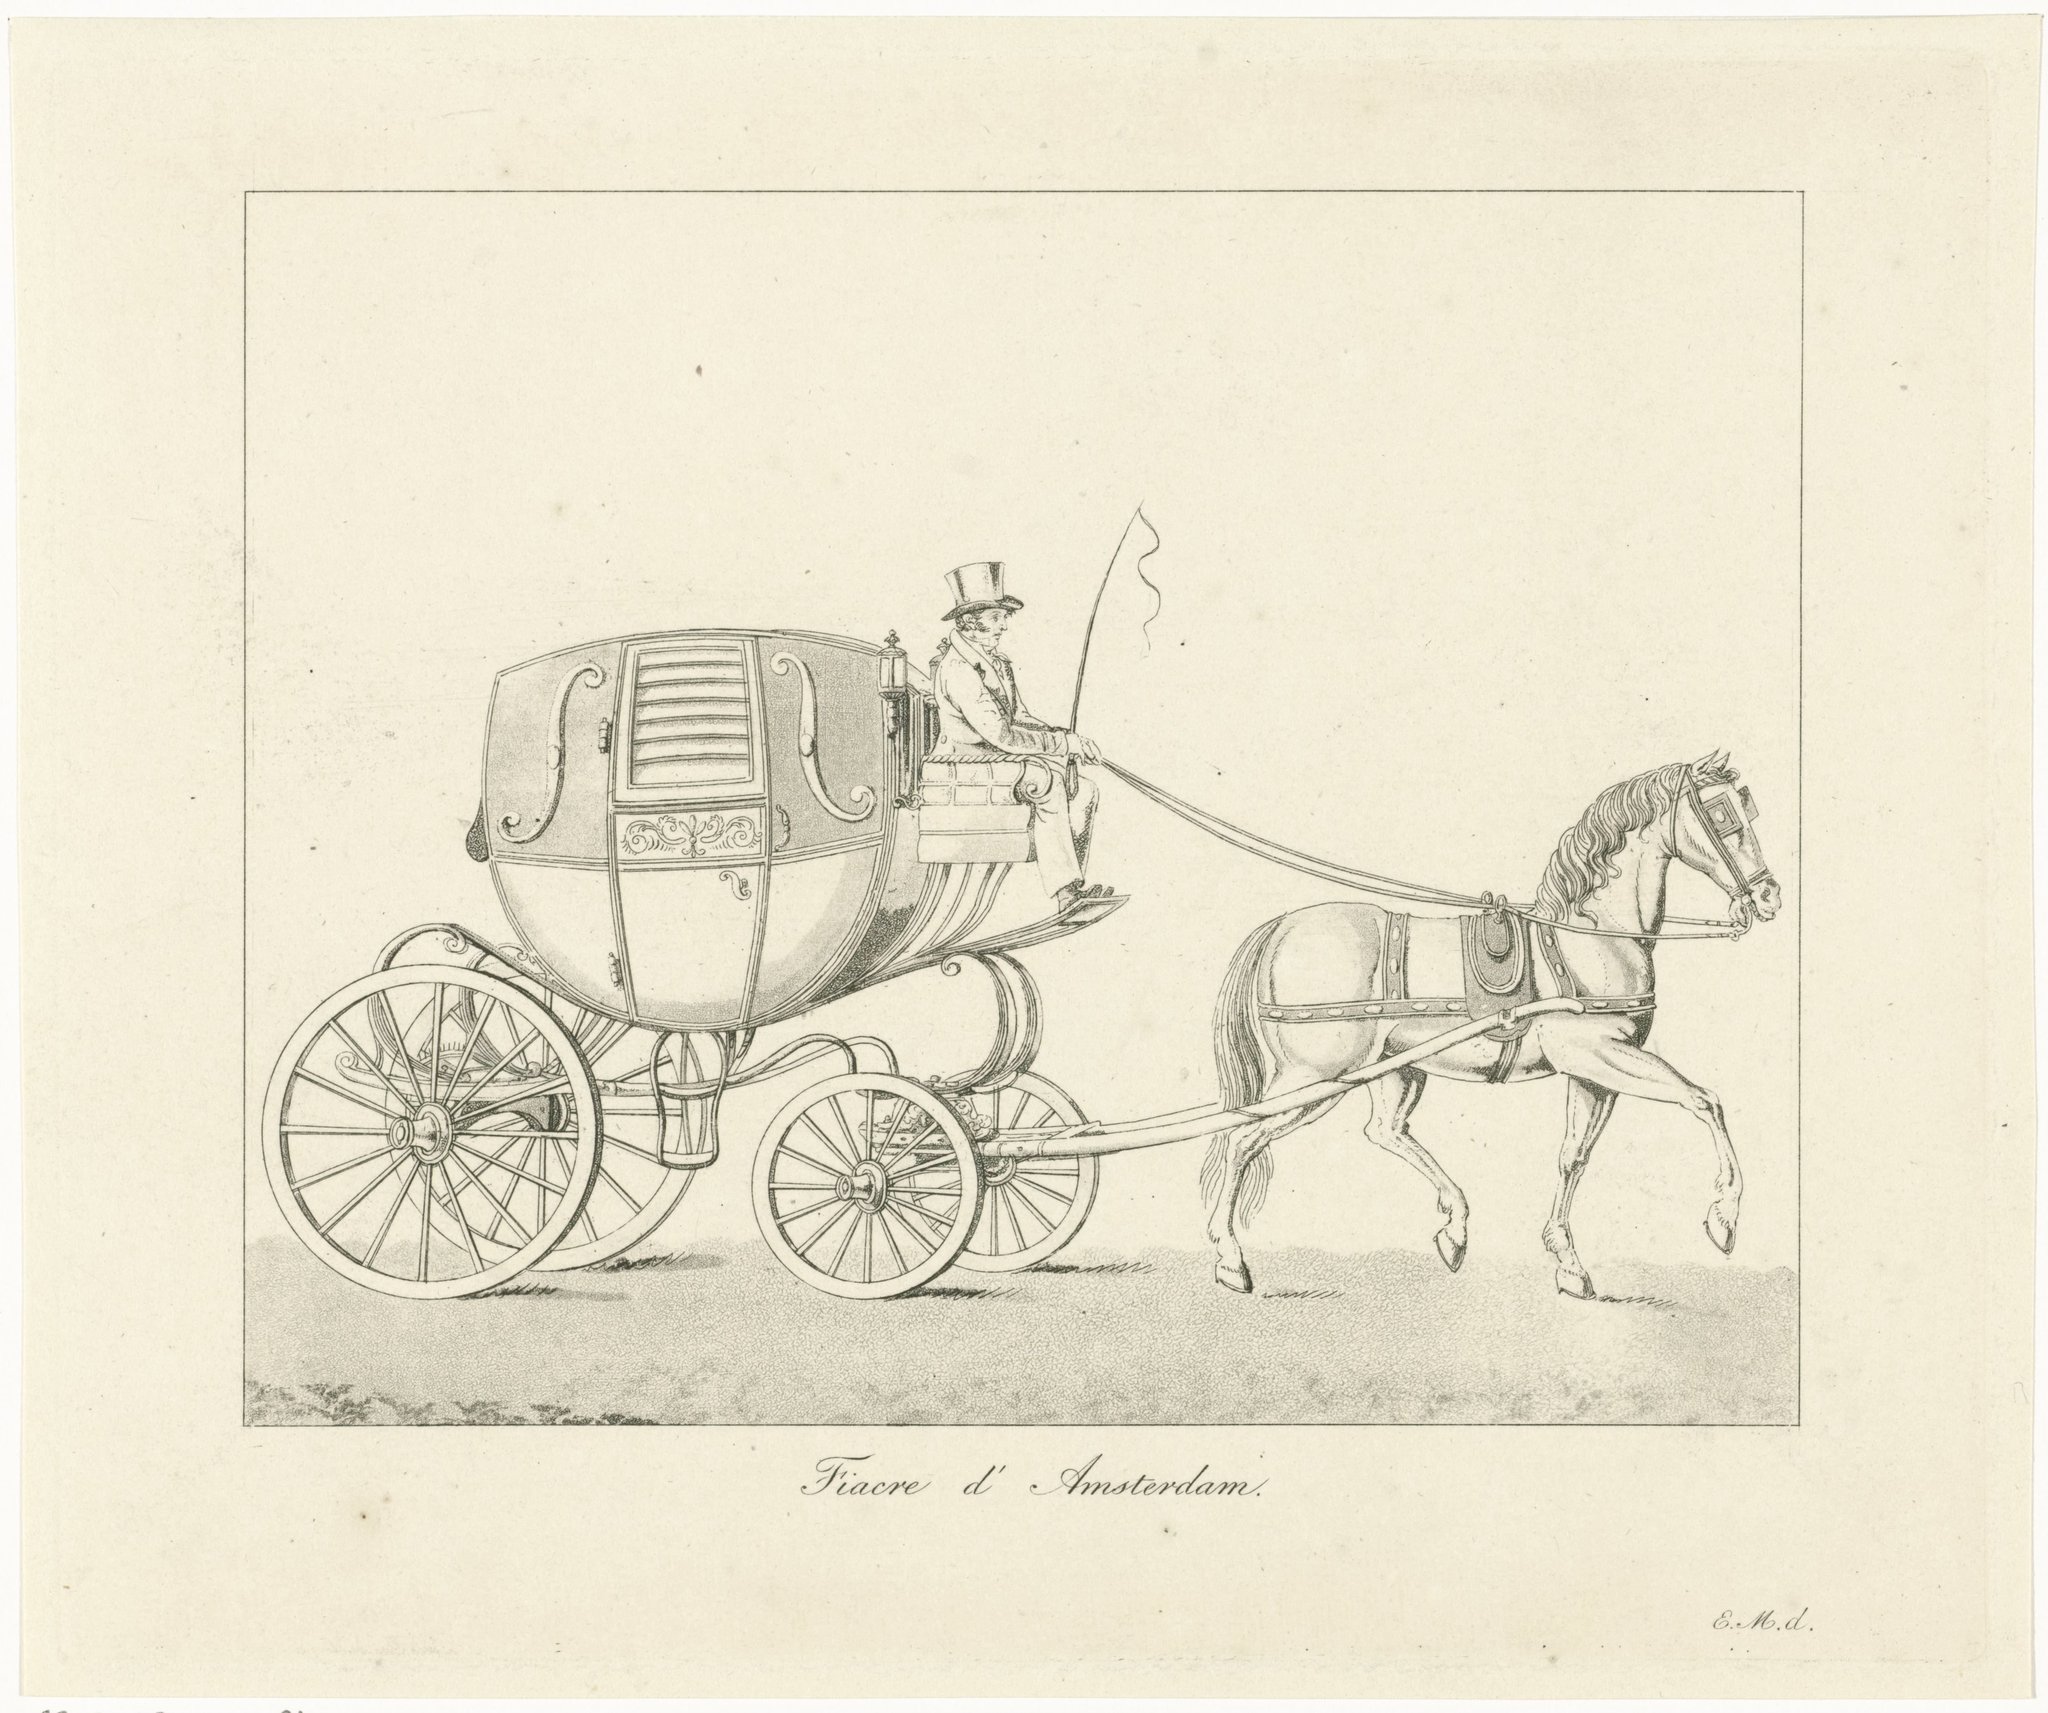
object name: print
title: Fiacre d' Amsterdam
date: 1816-1833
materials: paper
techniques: aquatint, etching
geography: amsterdam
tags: four-wheeled vehicle drawn by one animal, whip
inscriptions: collector's mark: Lugt 2228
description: Prent ook gebruikt in: Maaskamp, Evert. Tableau des principales vues des palais et édifices : représentations et des coutumes et usages, dans les provinces septentrionales du Royaume des Pays-Bas. Amsterdam, Evert Maaskamp, 1824.